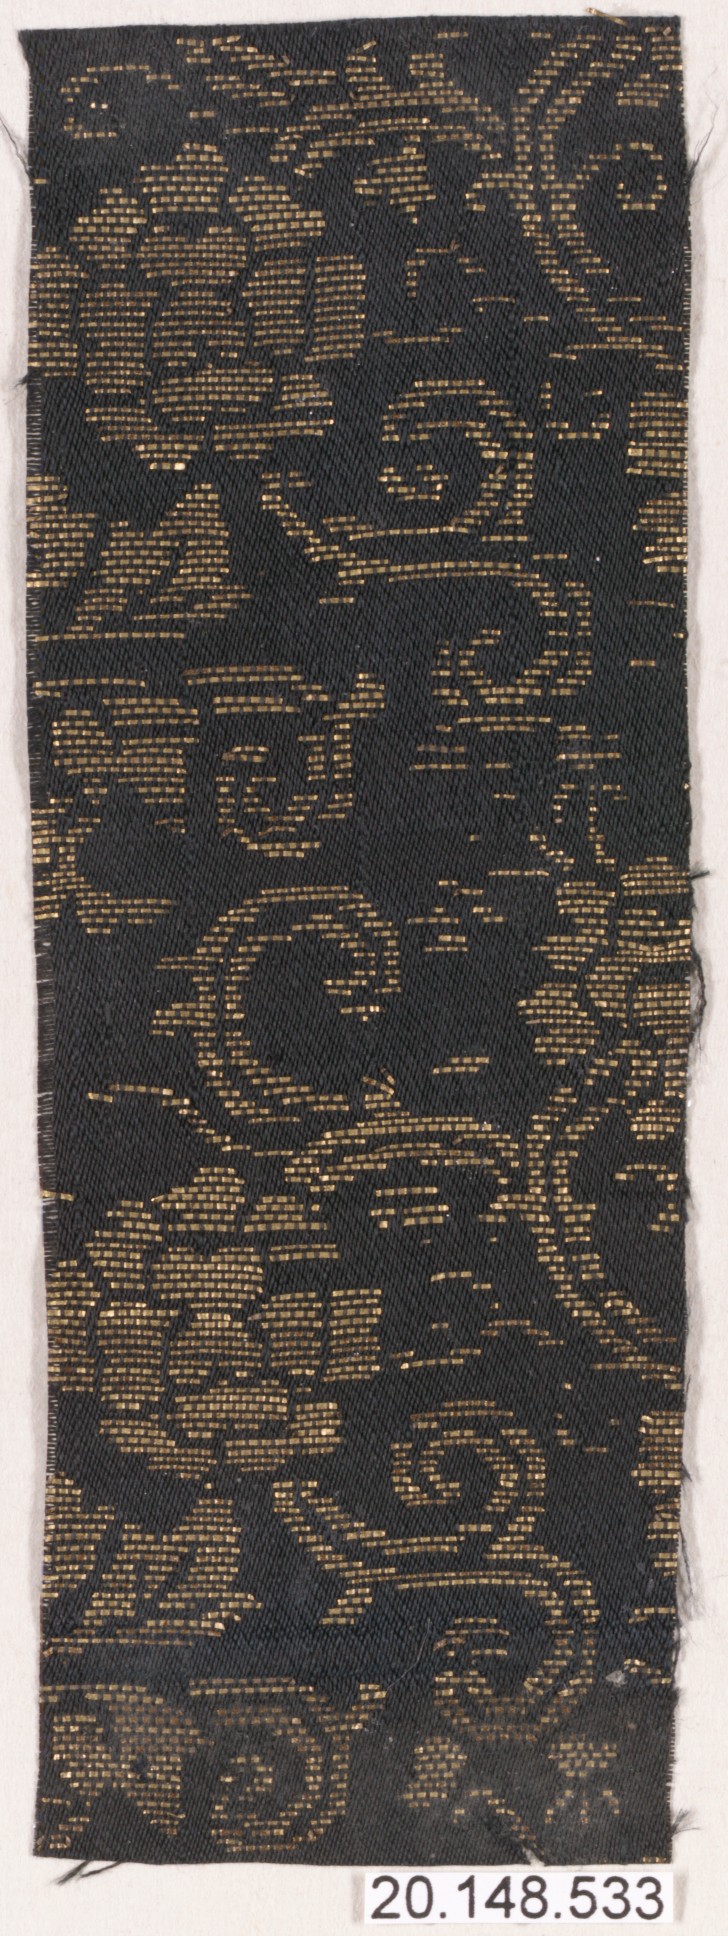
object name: piece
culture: japanese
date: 1701-1800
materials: silk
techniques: compound weave